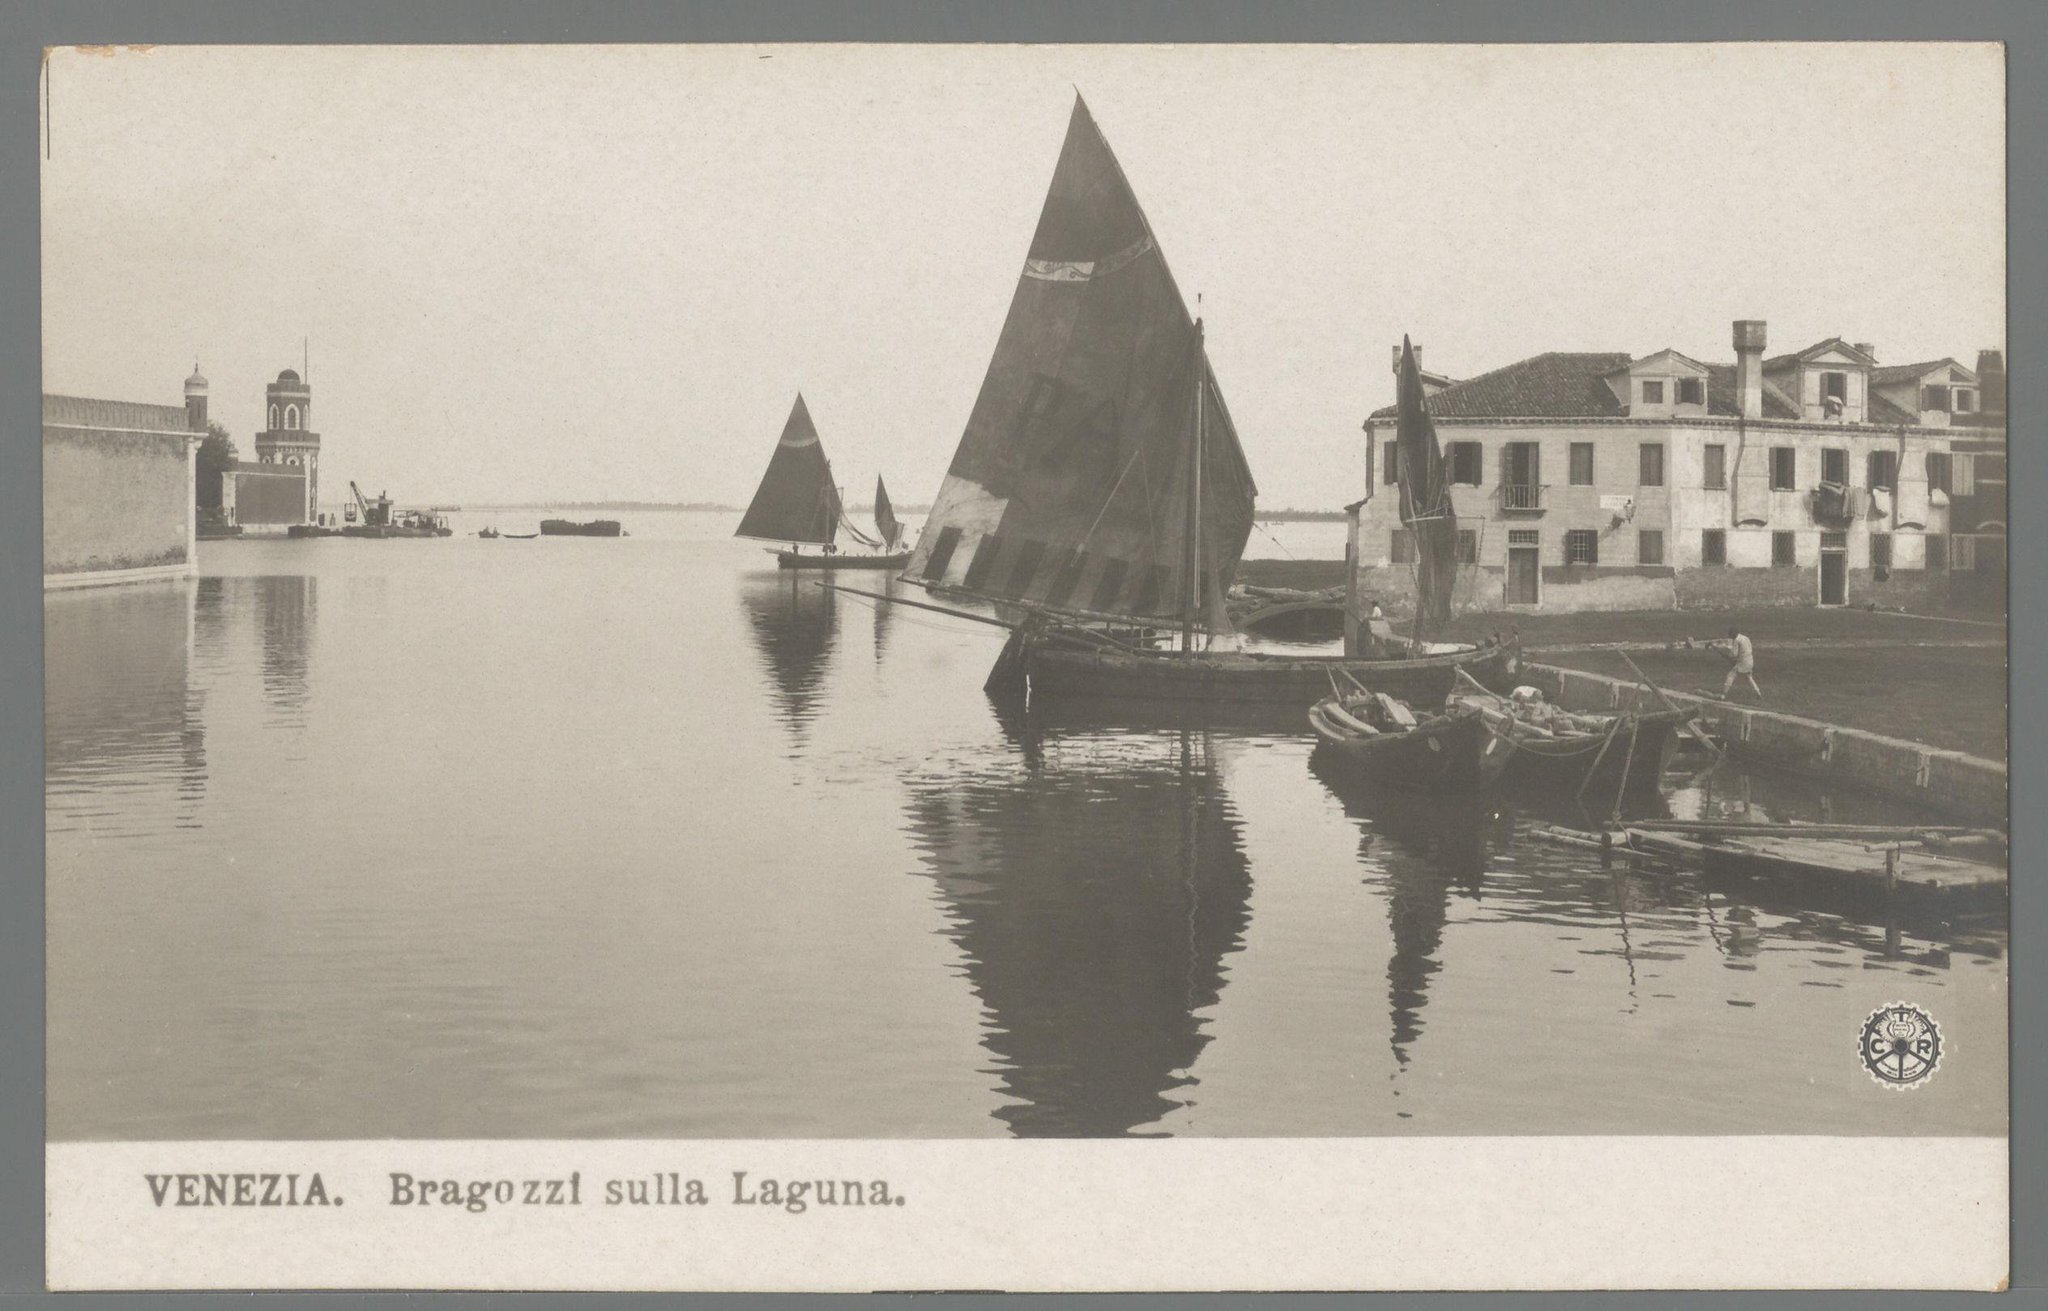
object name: photograph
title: Venezia. Bragozzi sulla Laguna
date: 1900-1906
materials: photographic support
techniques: photography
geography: milan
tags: sailing-ship, sailing-boat, city-view, and landscape with man-made constructions (+ city(-scape) with figures, staffage), sea, venice